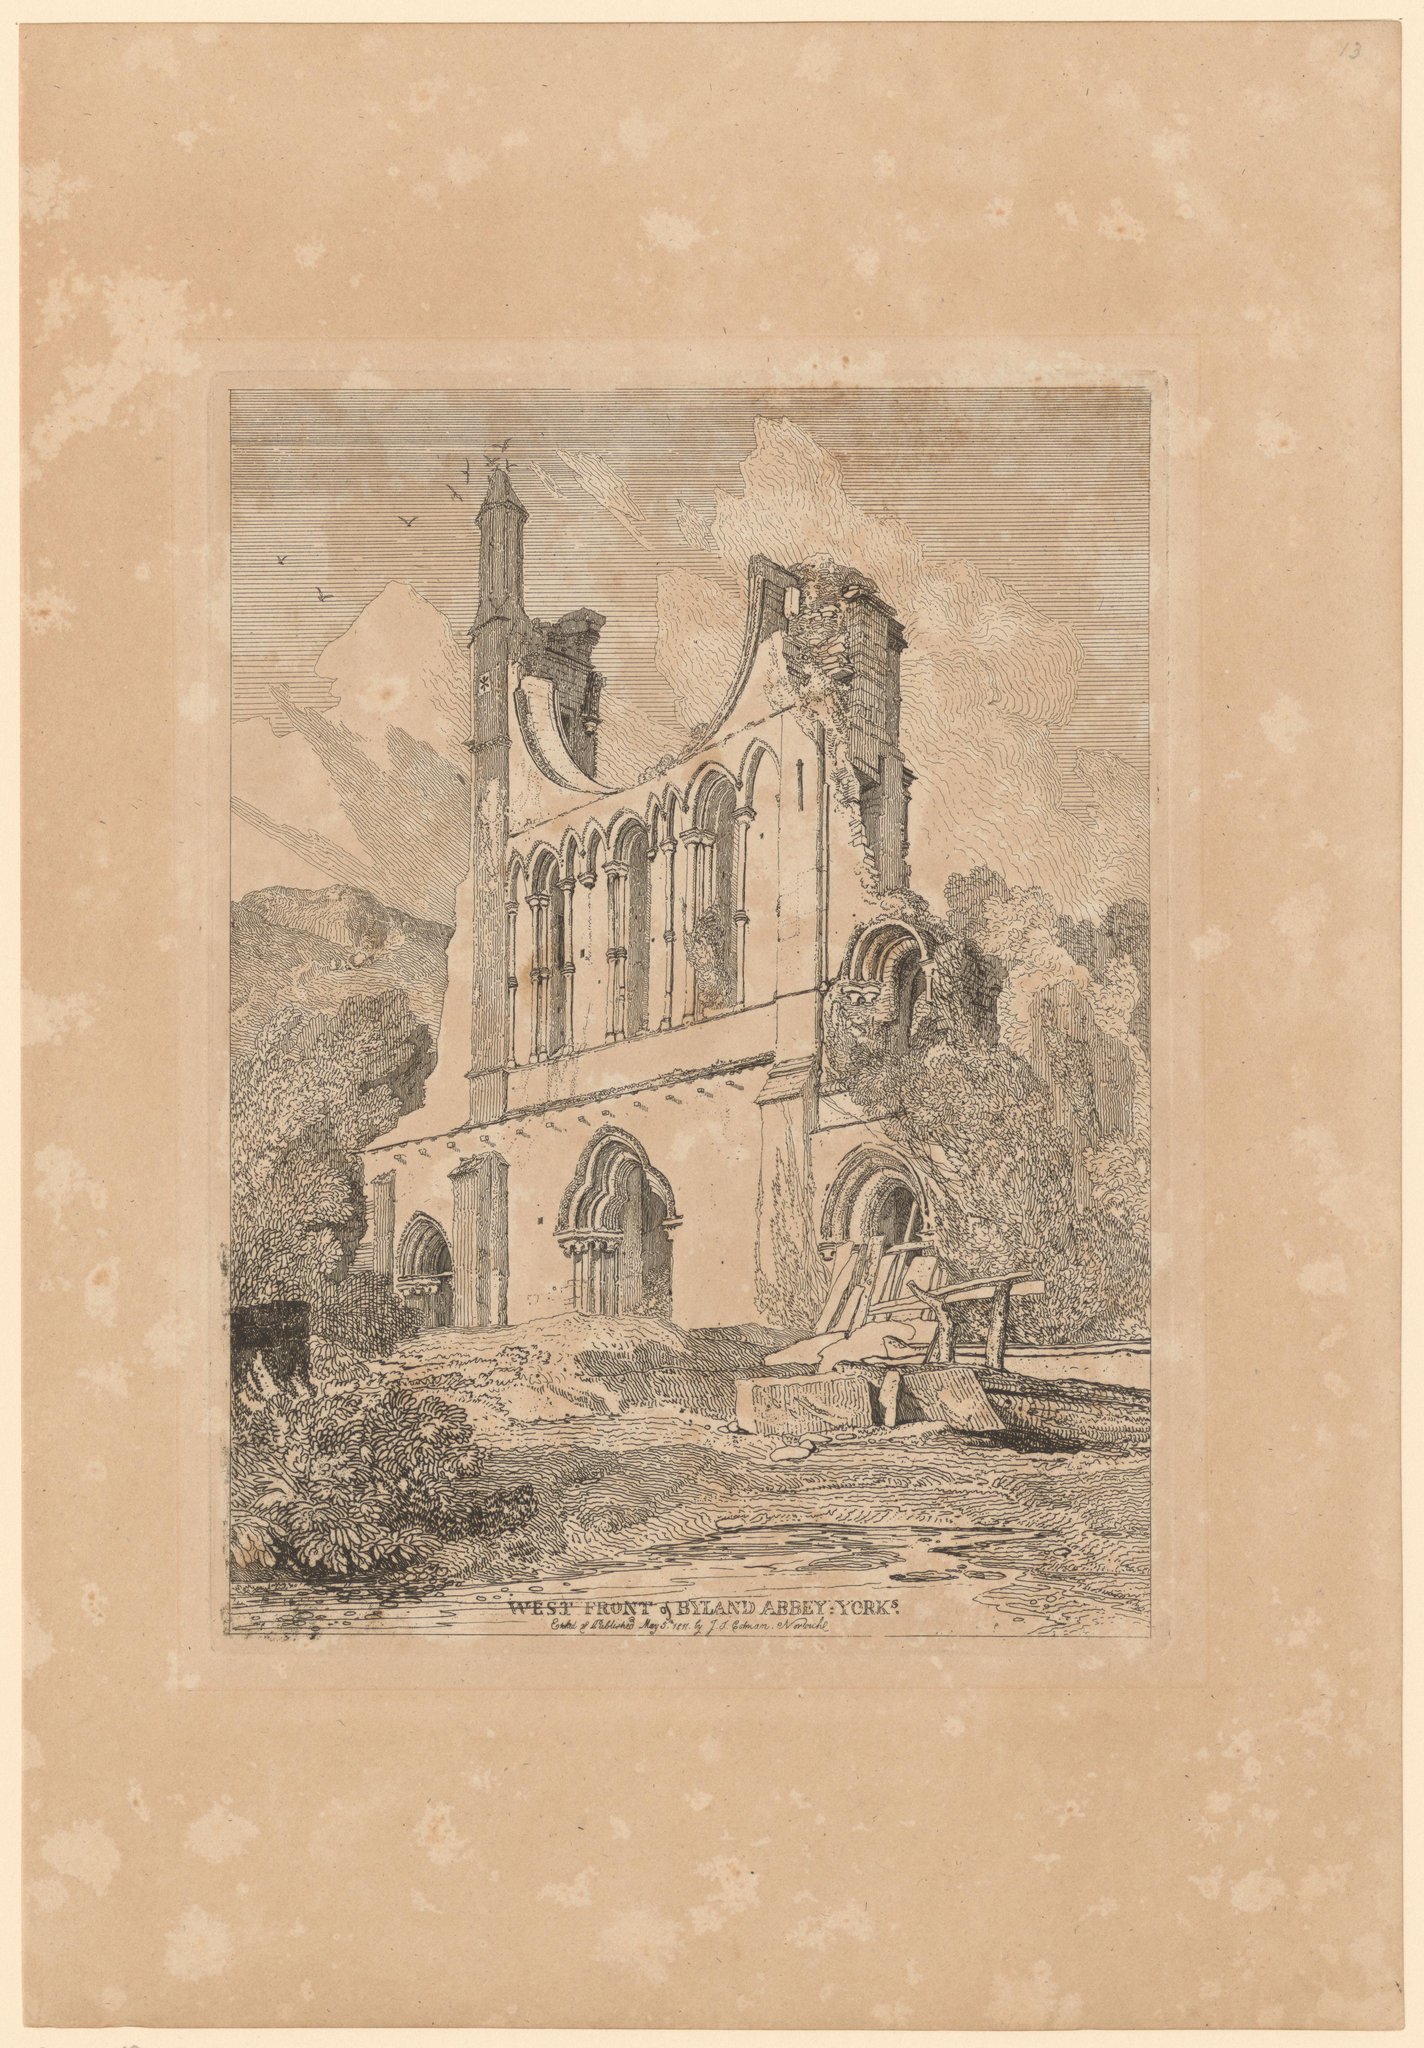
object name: print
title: West Front of Byland Abbey, Yorks[hire]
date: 1805-1811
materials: paper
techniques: etching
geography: norwich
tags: ruin of church, monastery, etc.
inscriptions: collector's mark: Lugt 2228, collector's mark: Lugt 2760